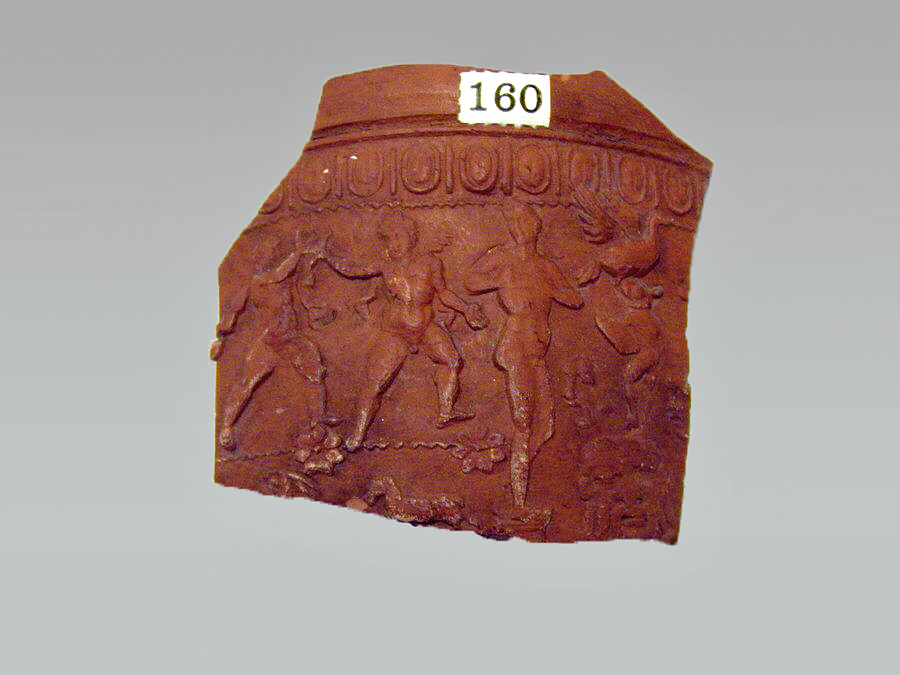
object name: vase fragment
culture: roman, gaul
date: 120 BCE-300 CE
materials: terracotta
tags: male nudes